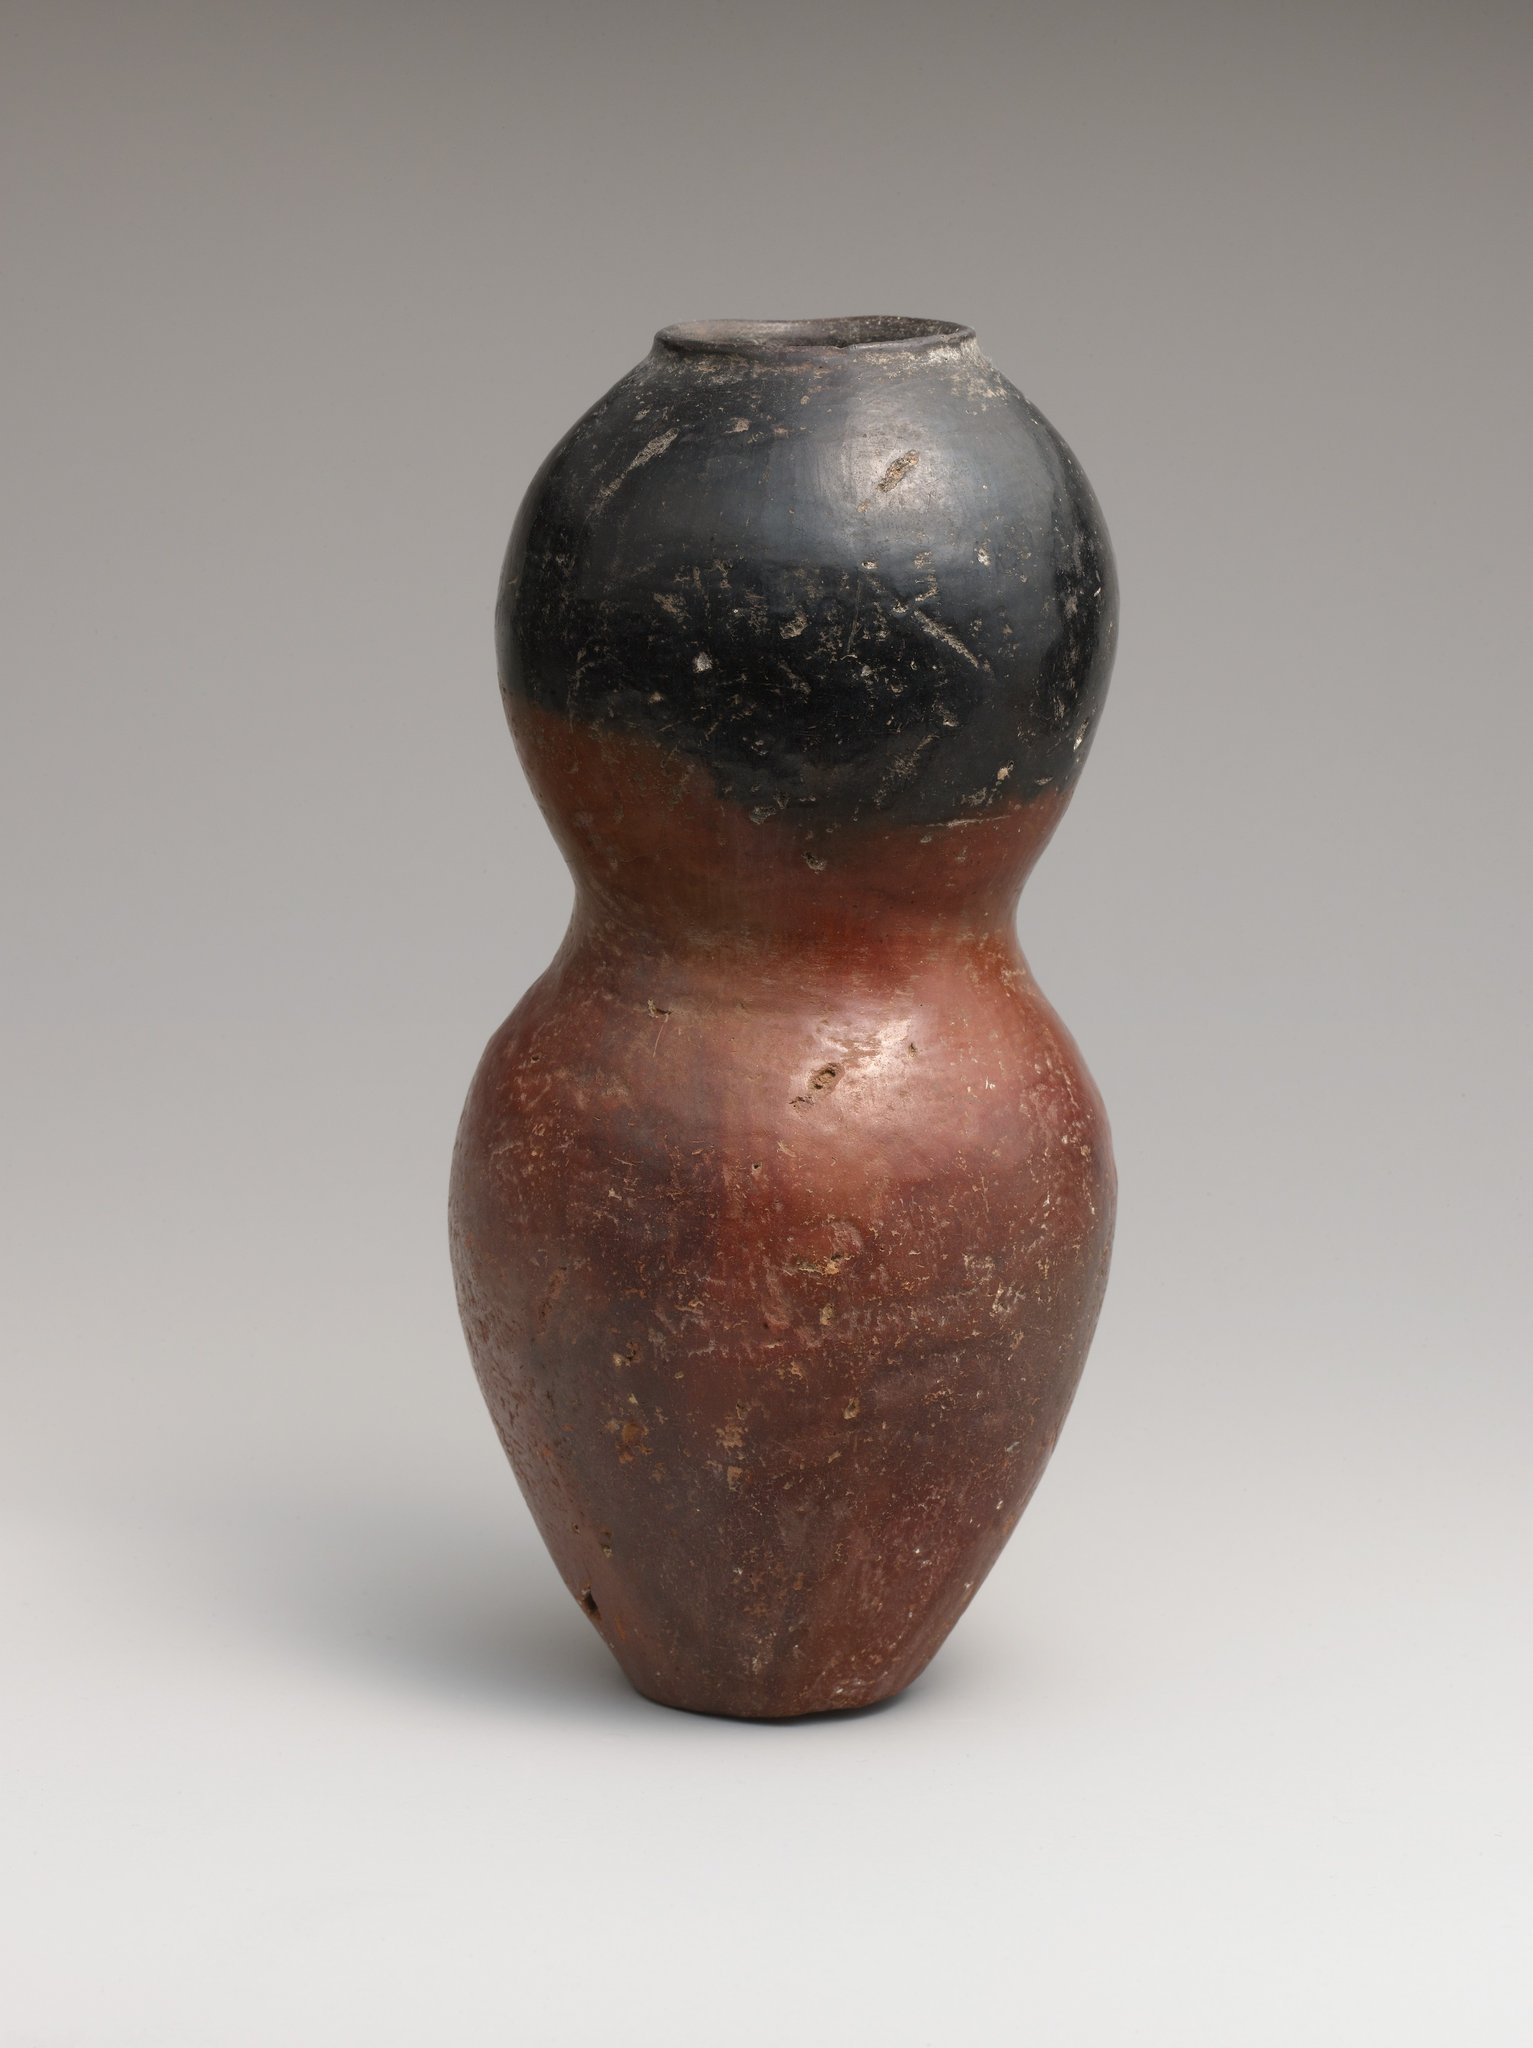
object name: jar, black topped red ware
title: Black-topped red ware jar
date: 3700-3500 BCE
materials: paint, pottery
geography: northern upper egypt